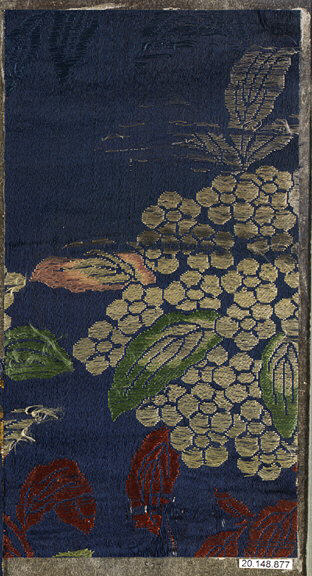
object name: piece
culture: chinese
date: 1601-1700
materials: silk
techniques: compound weave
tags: flowers,leaves